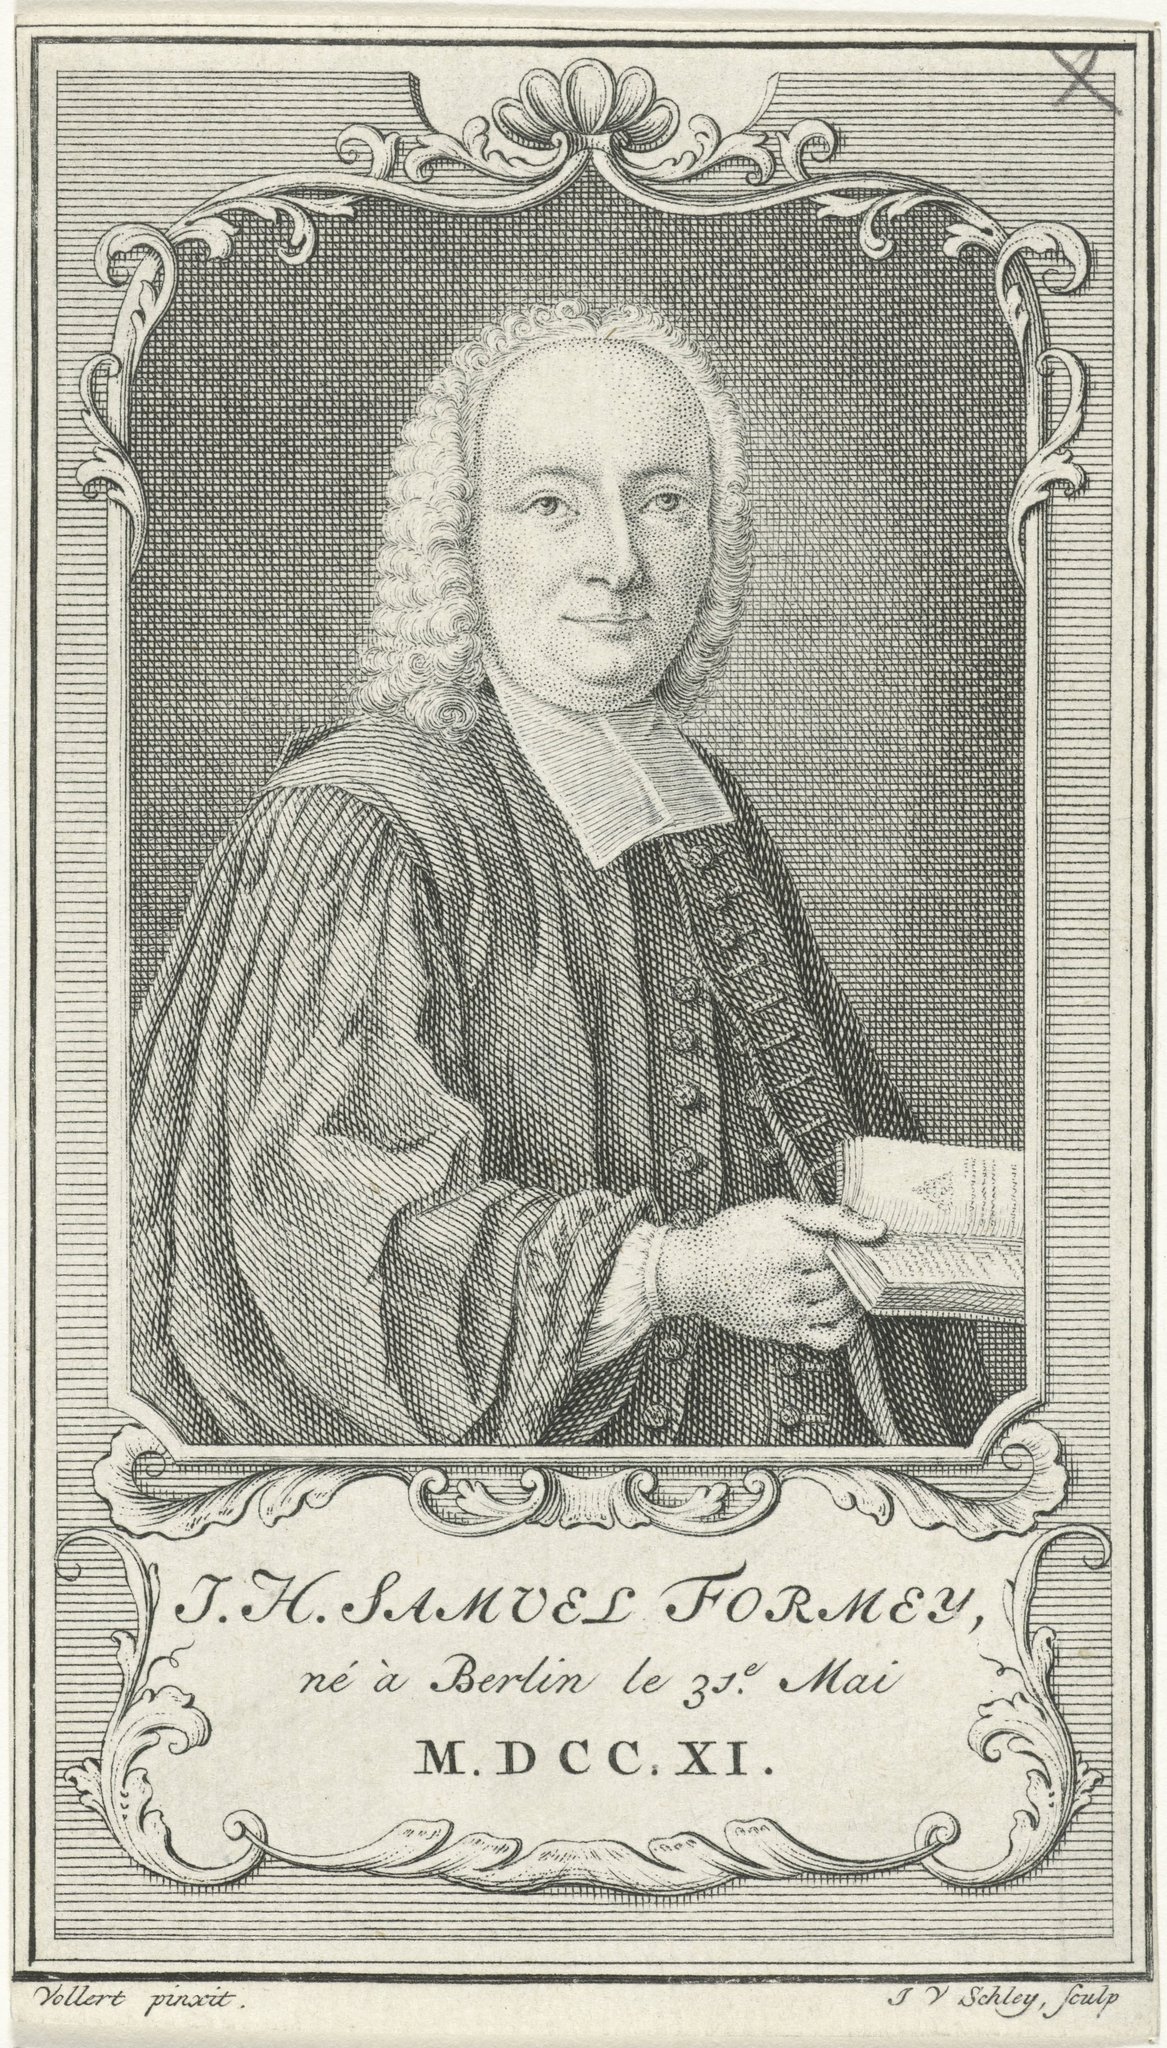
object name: print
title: Portret van Jean-Henri-Samuel Formey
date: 1725-1779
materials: paper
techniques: engraving, etching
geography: amsterdam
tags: berlin, book, wig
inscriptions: collector's mark: Lugt 2233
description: Portret van de Duitse schrijver Jean-Henri-Samuel Formey. Hij draagt een pruik en heeft in zijn hand een boek. Onder het portret zijn naam, geboortejaar en geboorteplaats.